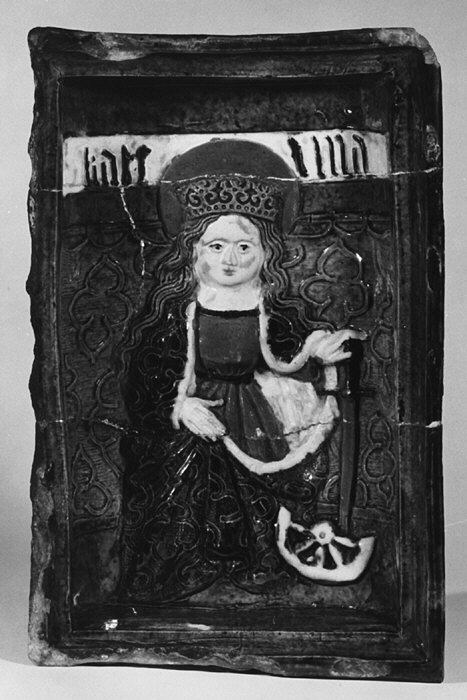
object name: stove tile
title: Saint Catherine of Alexandria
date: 1500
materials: earthenware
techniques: glazing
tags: saint catherine